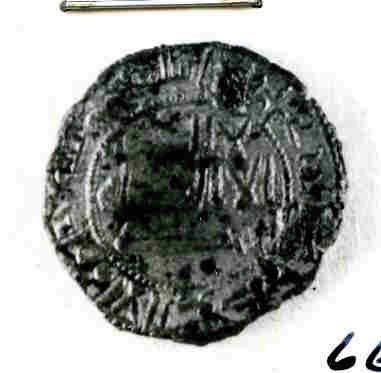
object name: coin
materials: copper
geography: iran